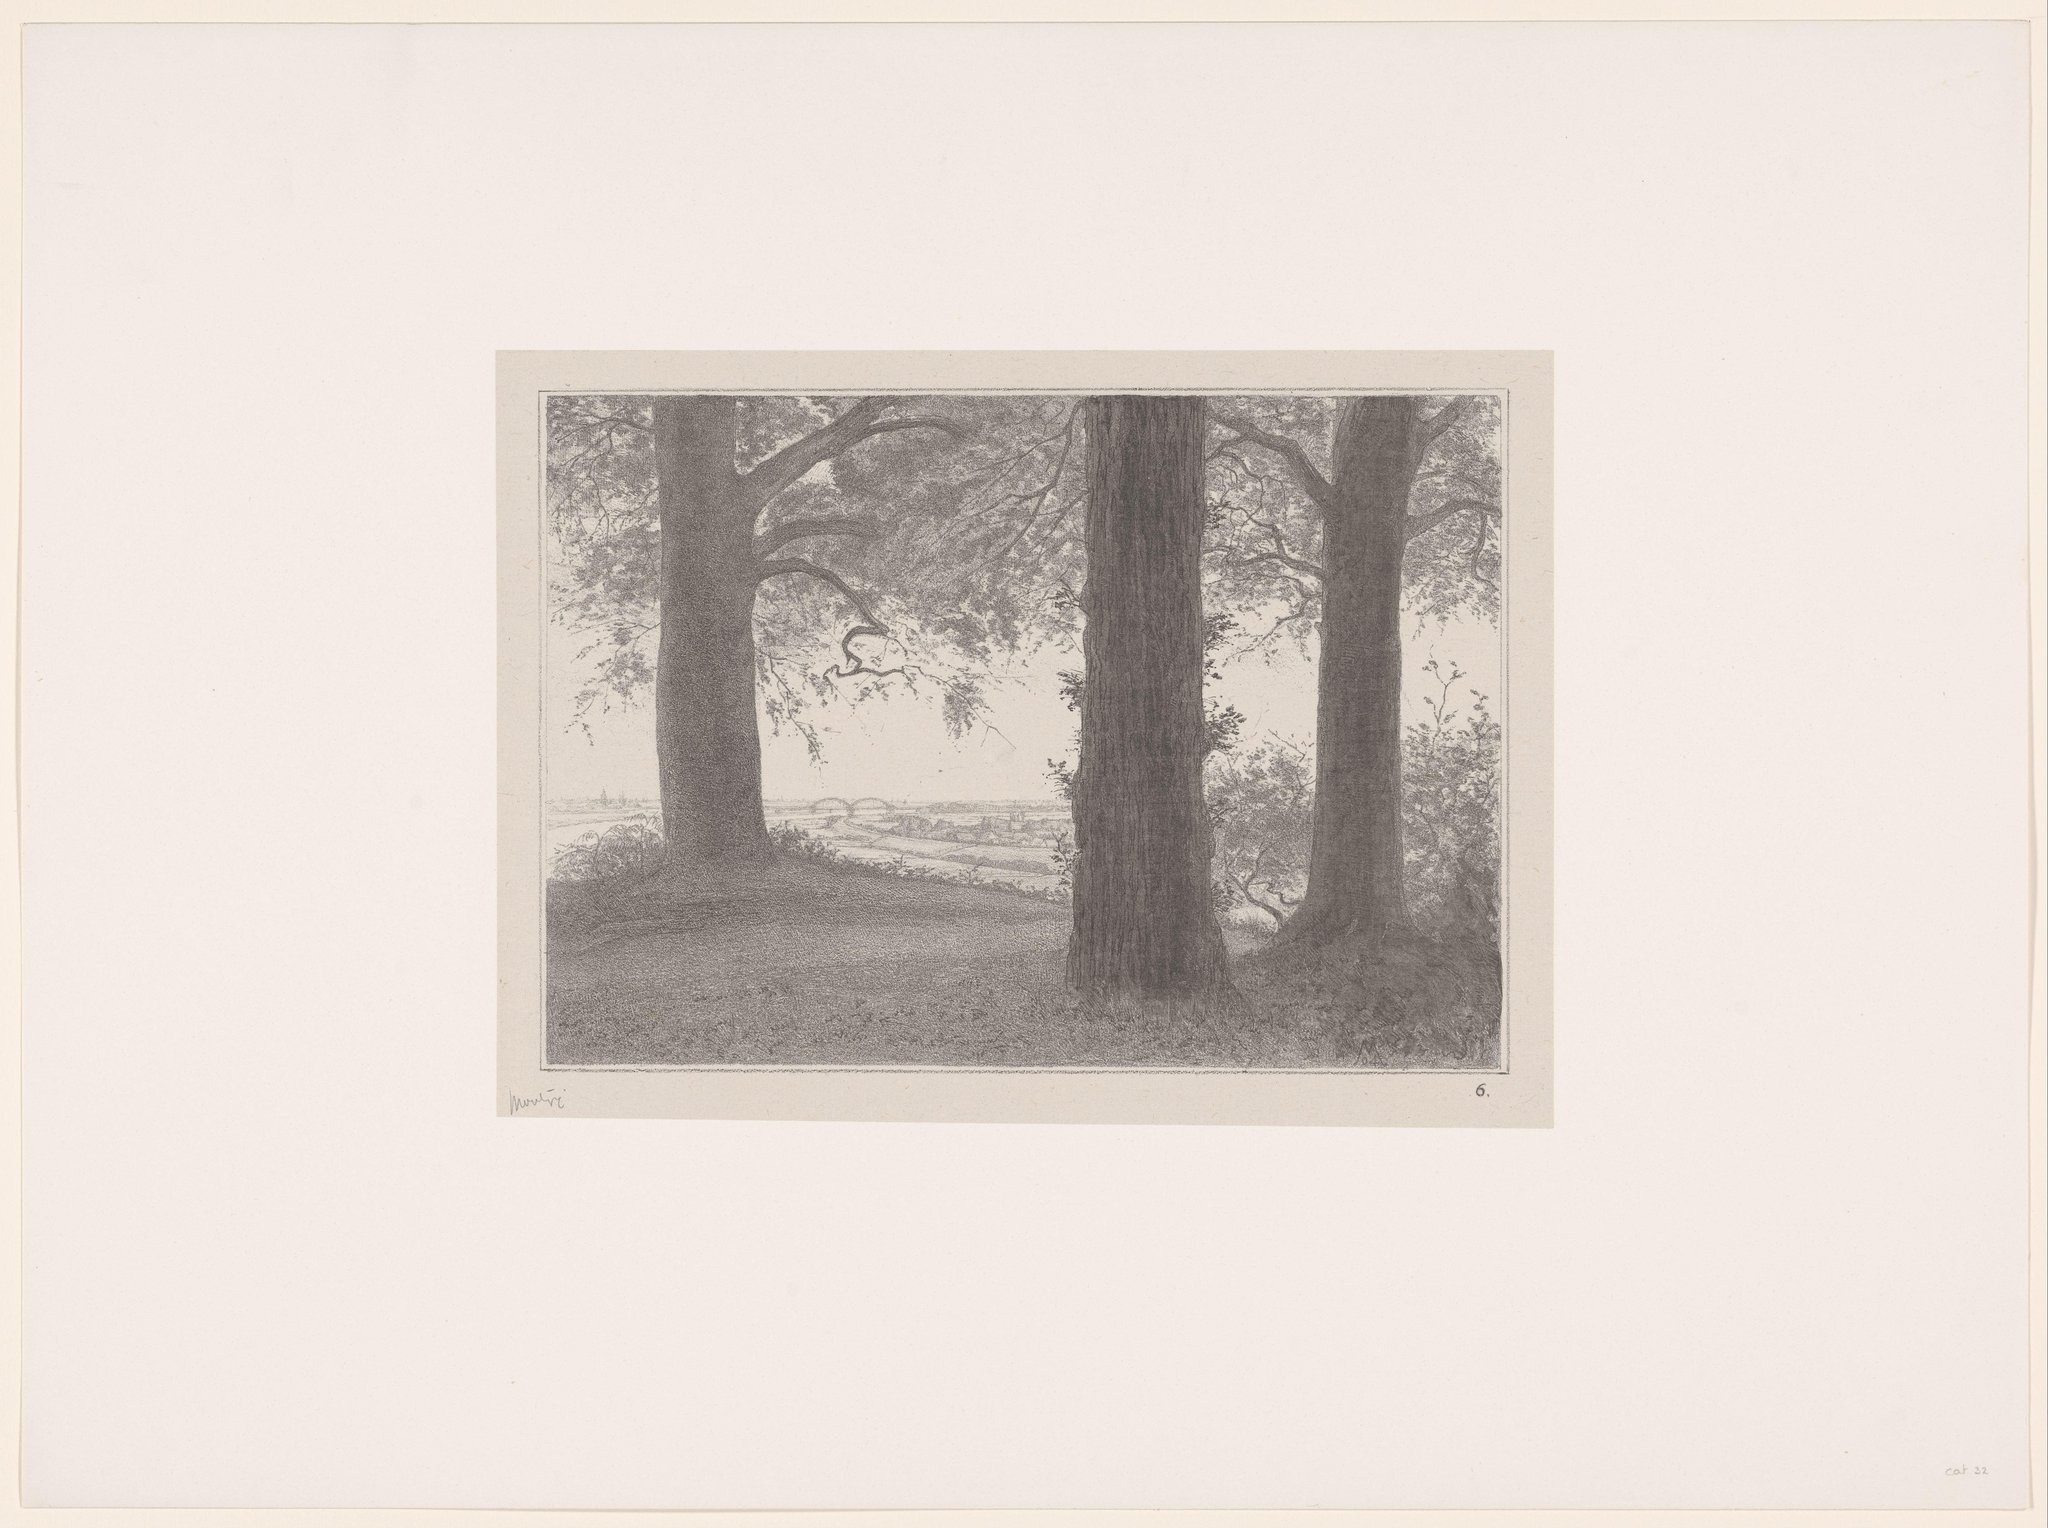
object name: print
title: De Duno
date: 1904-1905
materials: paper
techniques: lithograph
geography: doorwerth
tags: trees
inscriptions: collector's mark: Lugt 2228